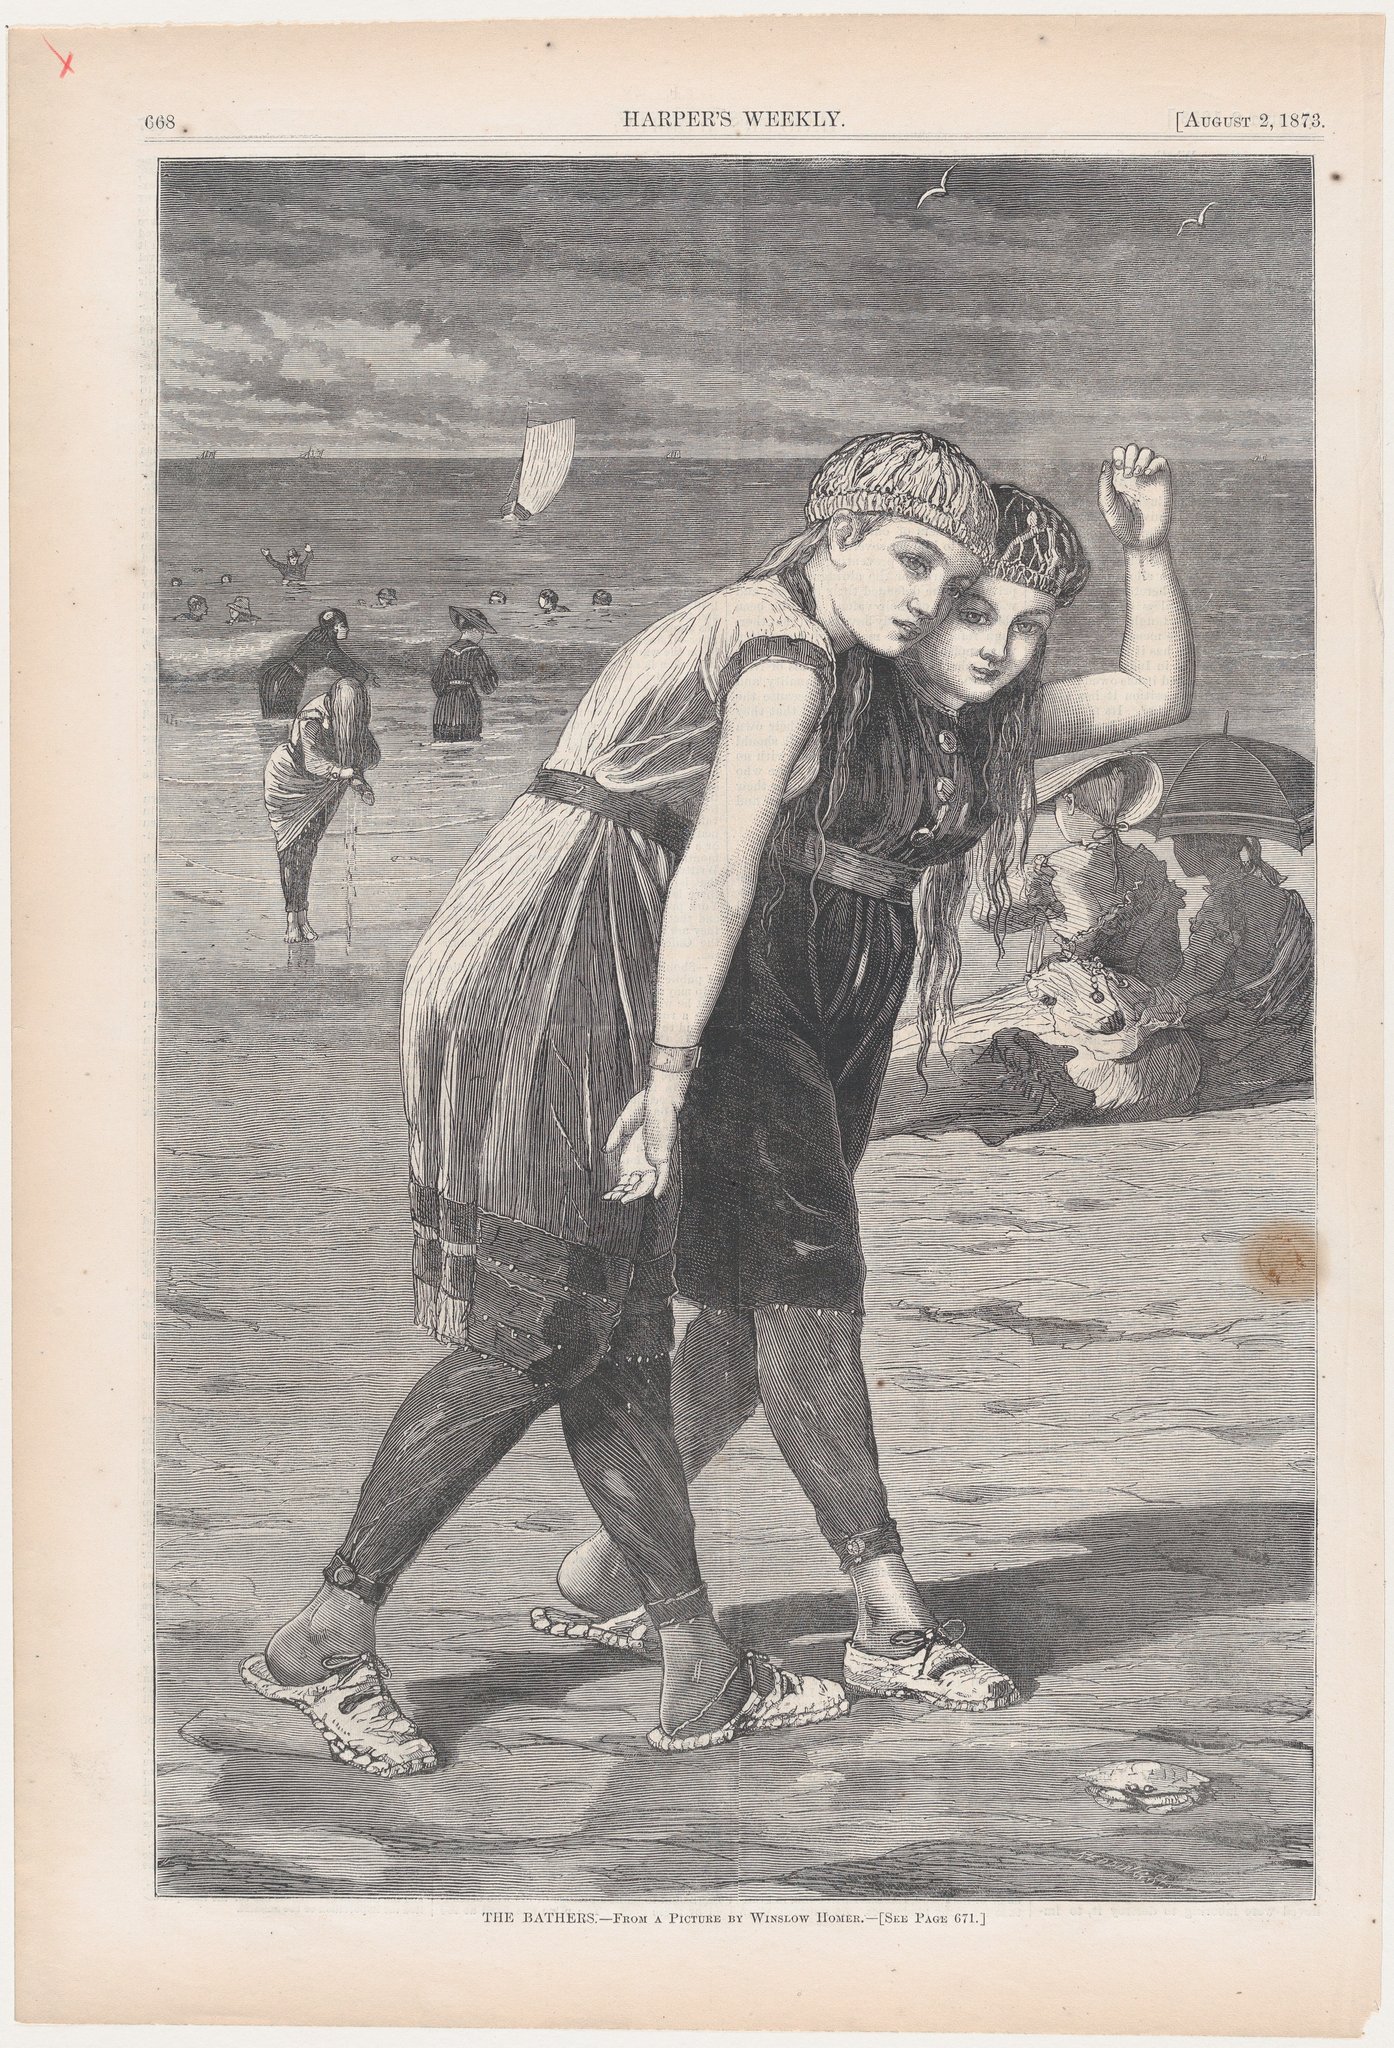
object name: print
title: The Bathers (from "Harper's Weekly," Vol. XVII)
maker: winslow homer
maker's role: artist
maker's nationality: american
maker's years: 1836-1910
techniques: engraving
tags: girls,beaches,boats